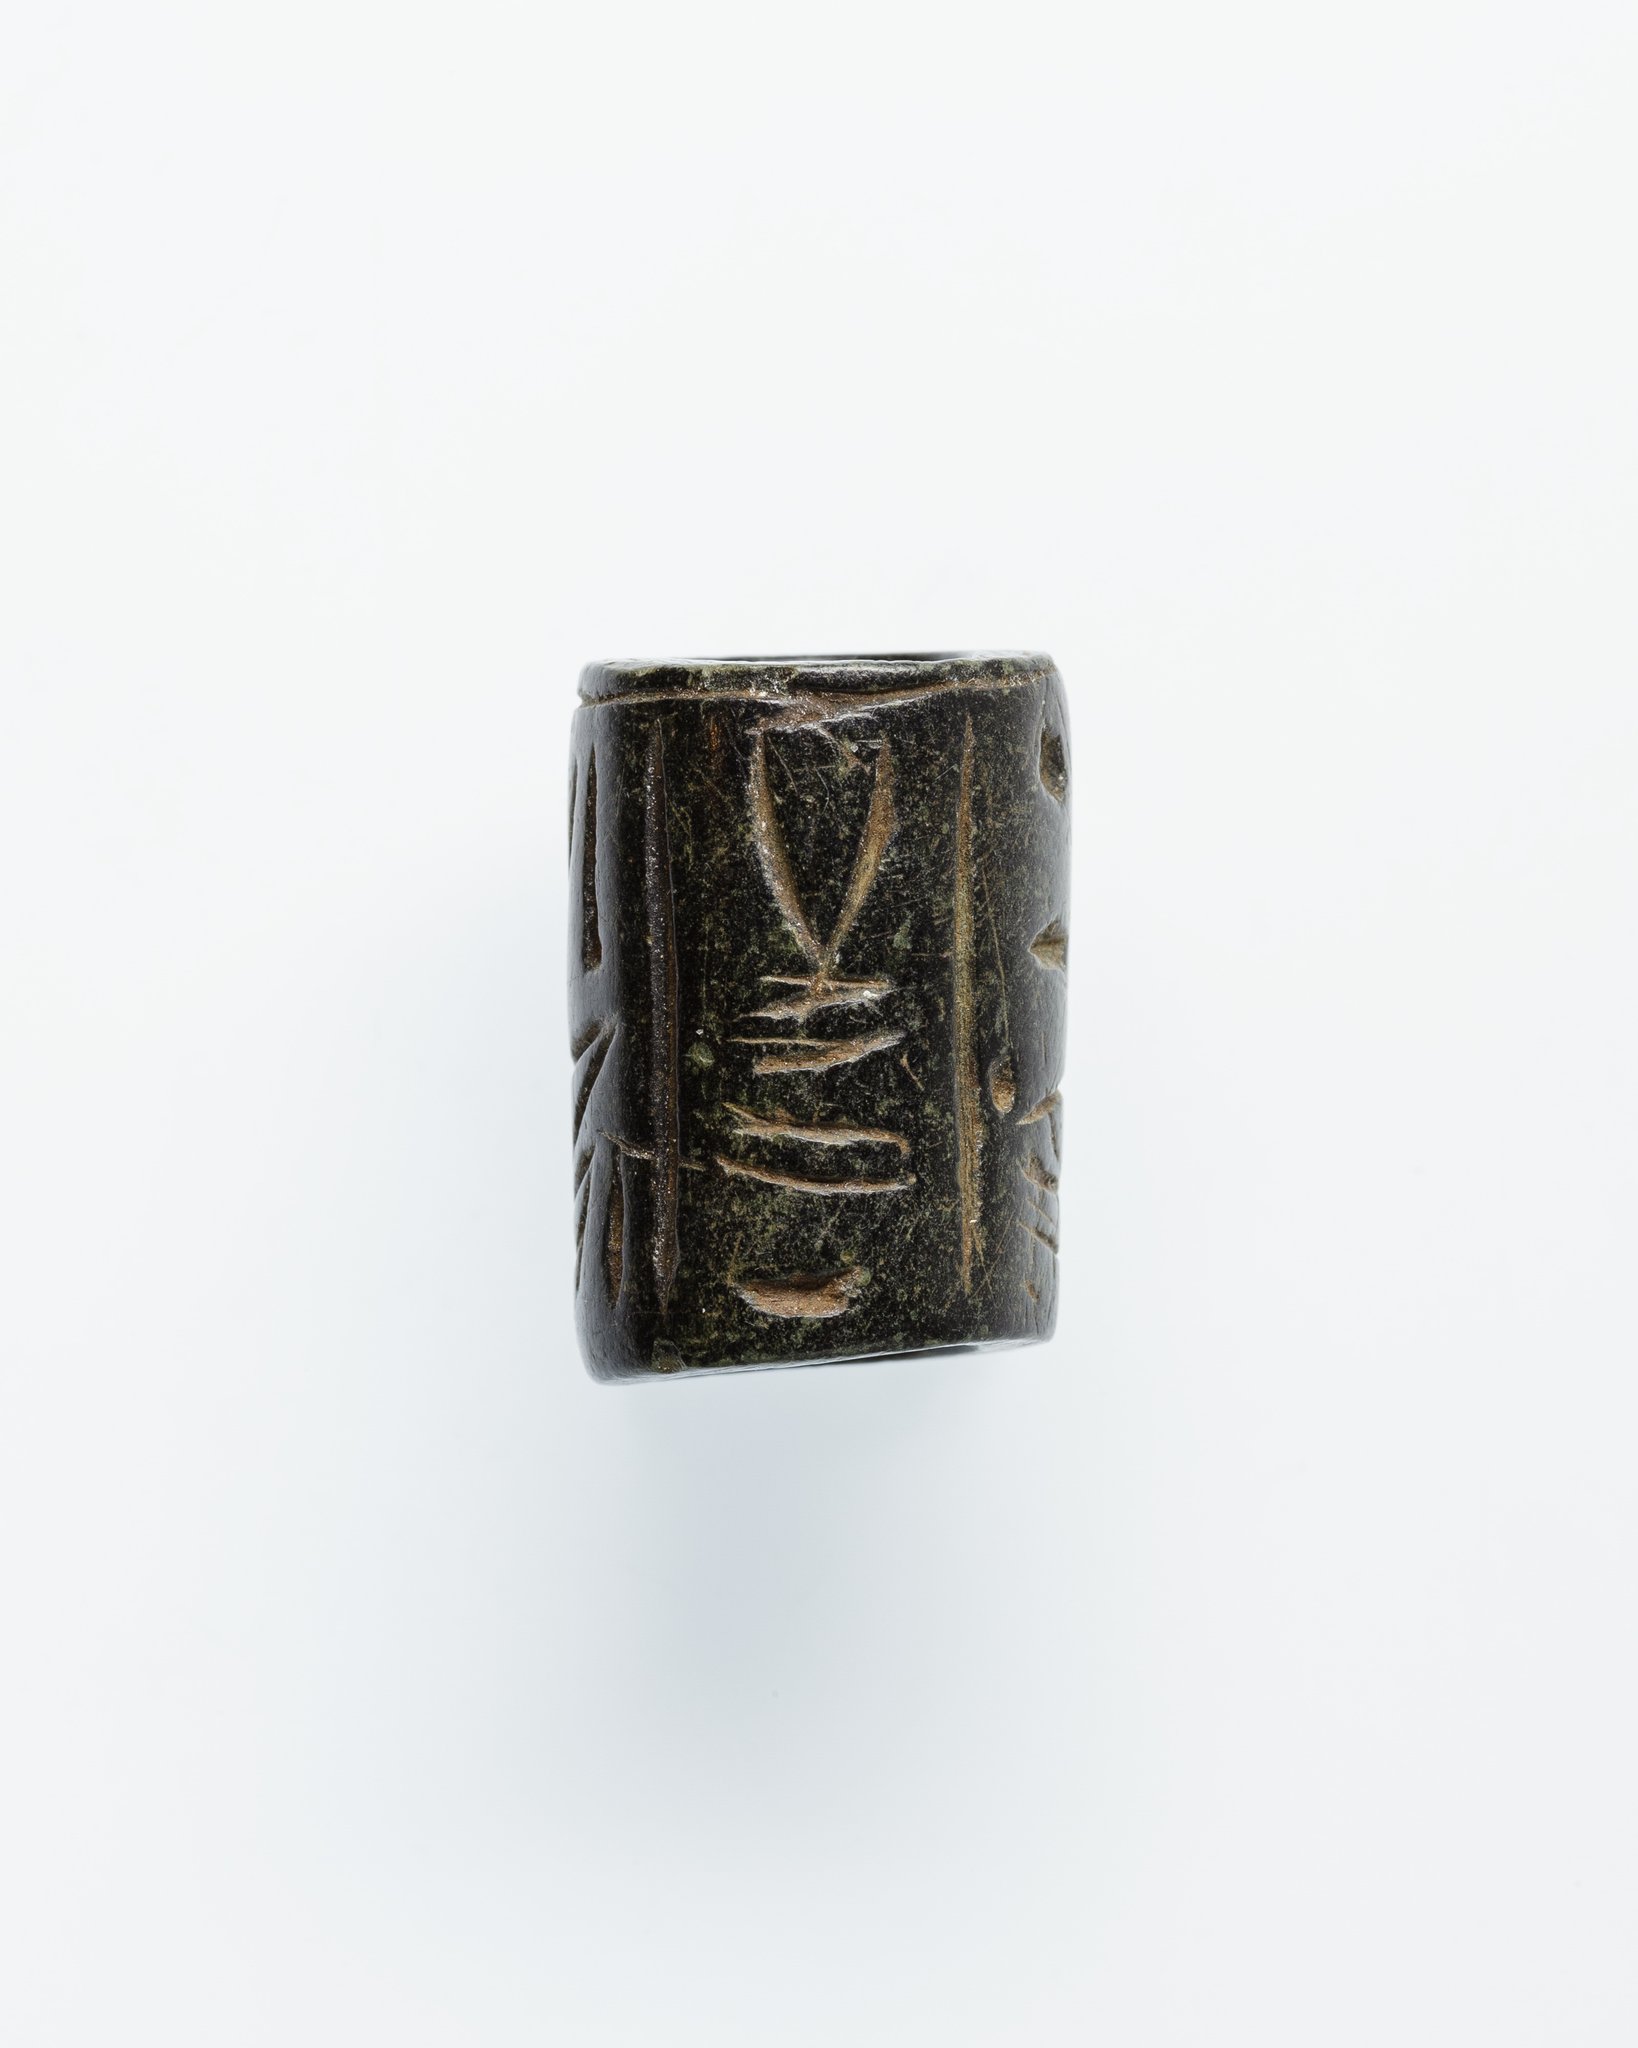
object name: cylinder seal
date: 2649-2100 BCE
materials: stone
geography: egypt